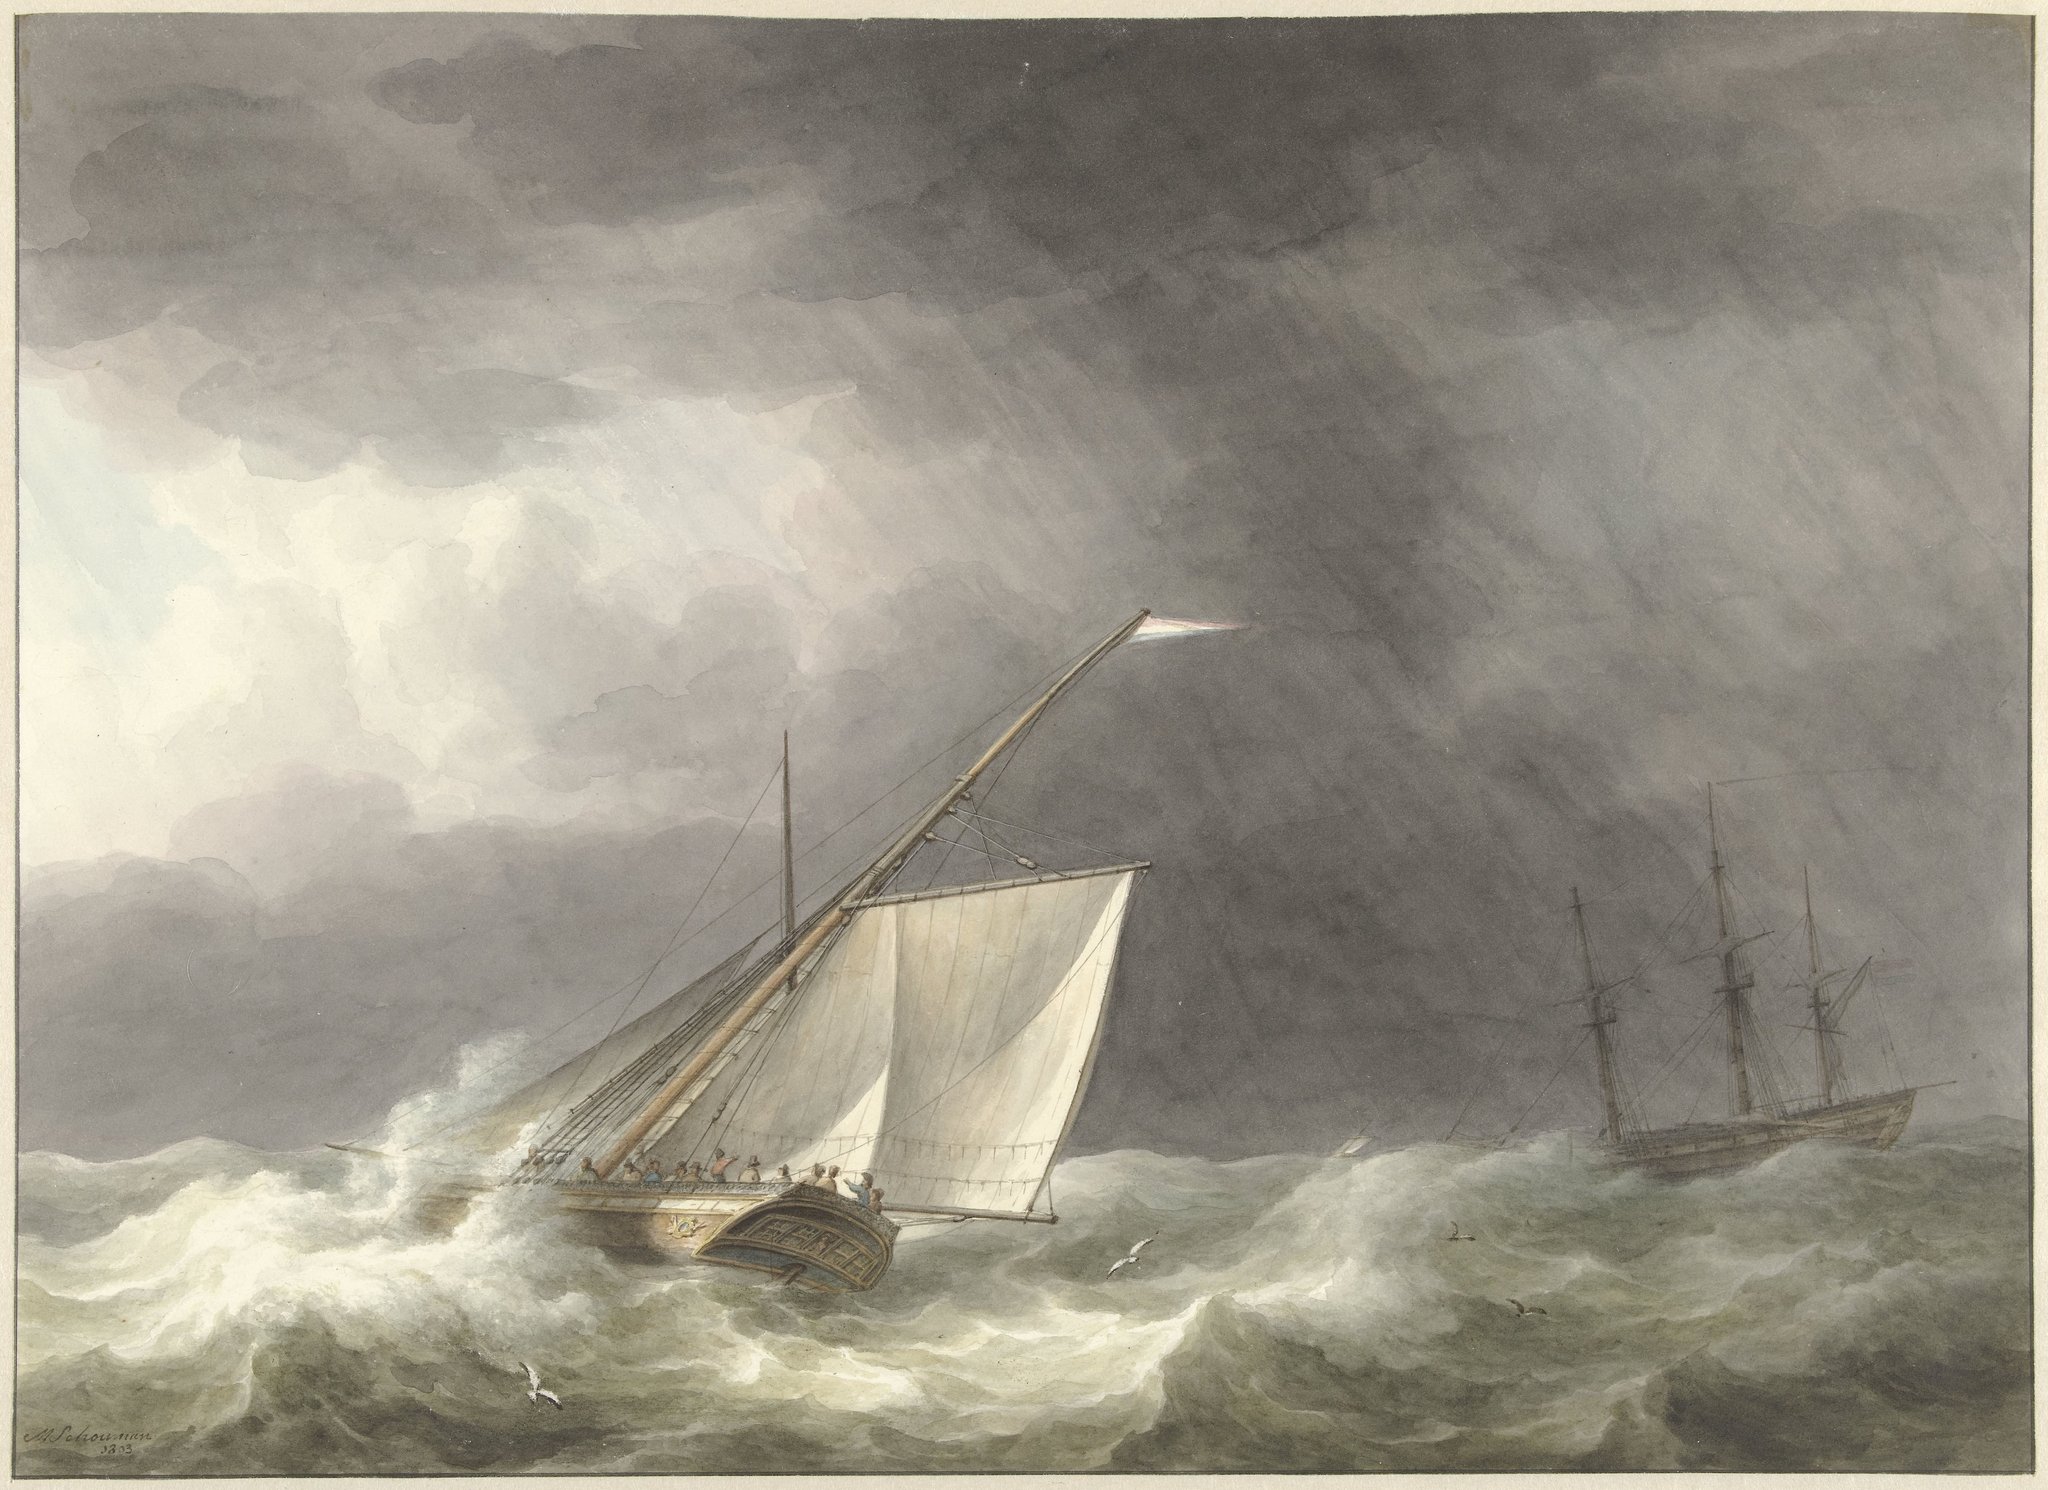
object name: watercolor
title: Twee zeilschepen op woelige zee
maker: martinus schouman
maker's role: draughtsman, painter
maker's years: 1770-1848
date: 1803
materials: ink, paper, watercolor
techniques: brush, pen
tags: sailing-ship, sailing-boat, sea (seascape), storm at sea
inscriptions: date